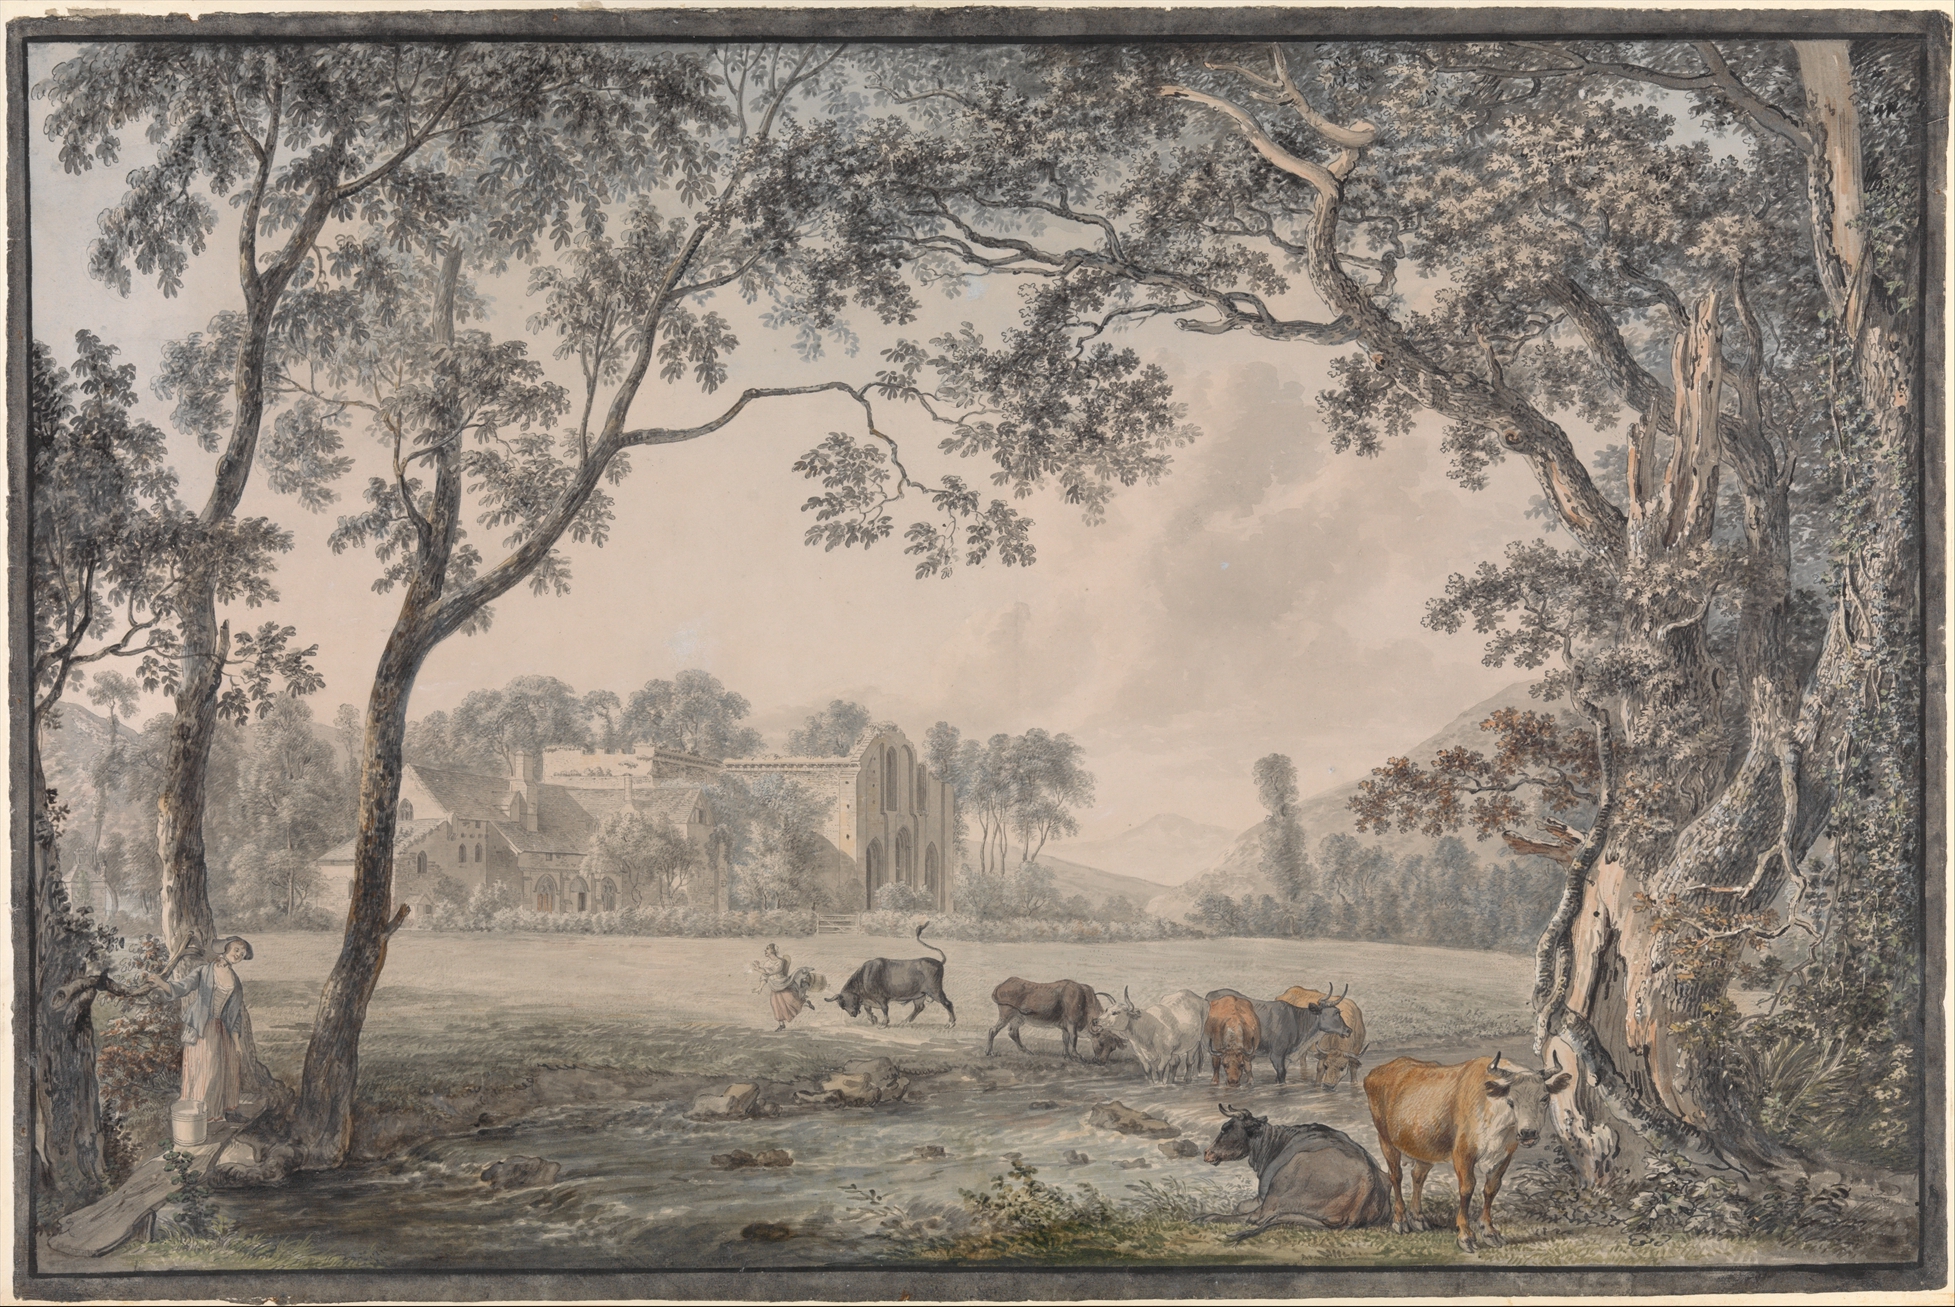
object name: drawing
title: Valle Crucis Abbey, Denbighshire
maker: paul sandby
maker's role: artist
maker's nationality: british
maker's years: 1731-1809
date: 1770-1779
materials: graphite, ink, watercolor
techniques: pen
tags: buildings,women,cows,trees